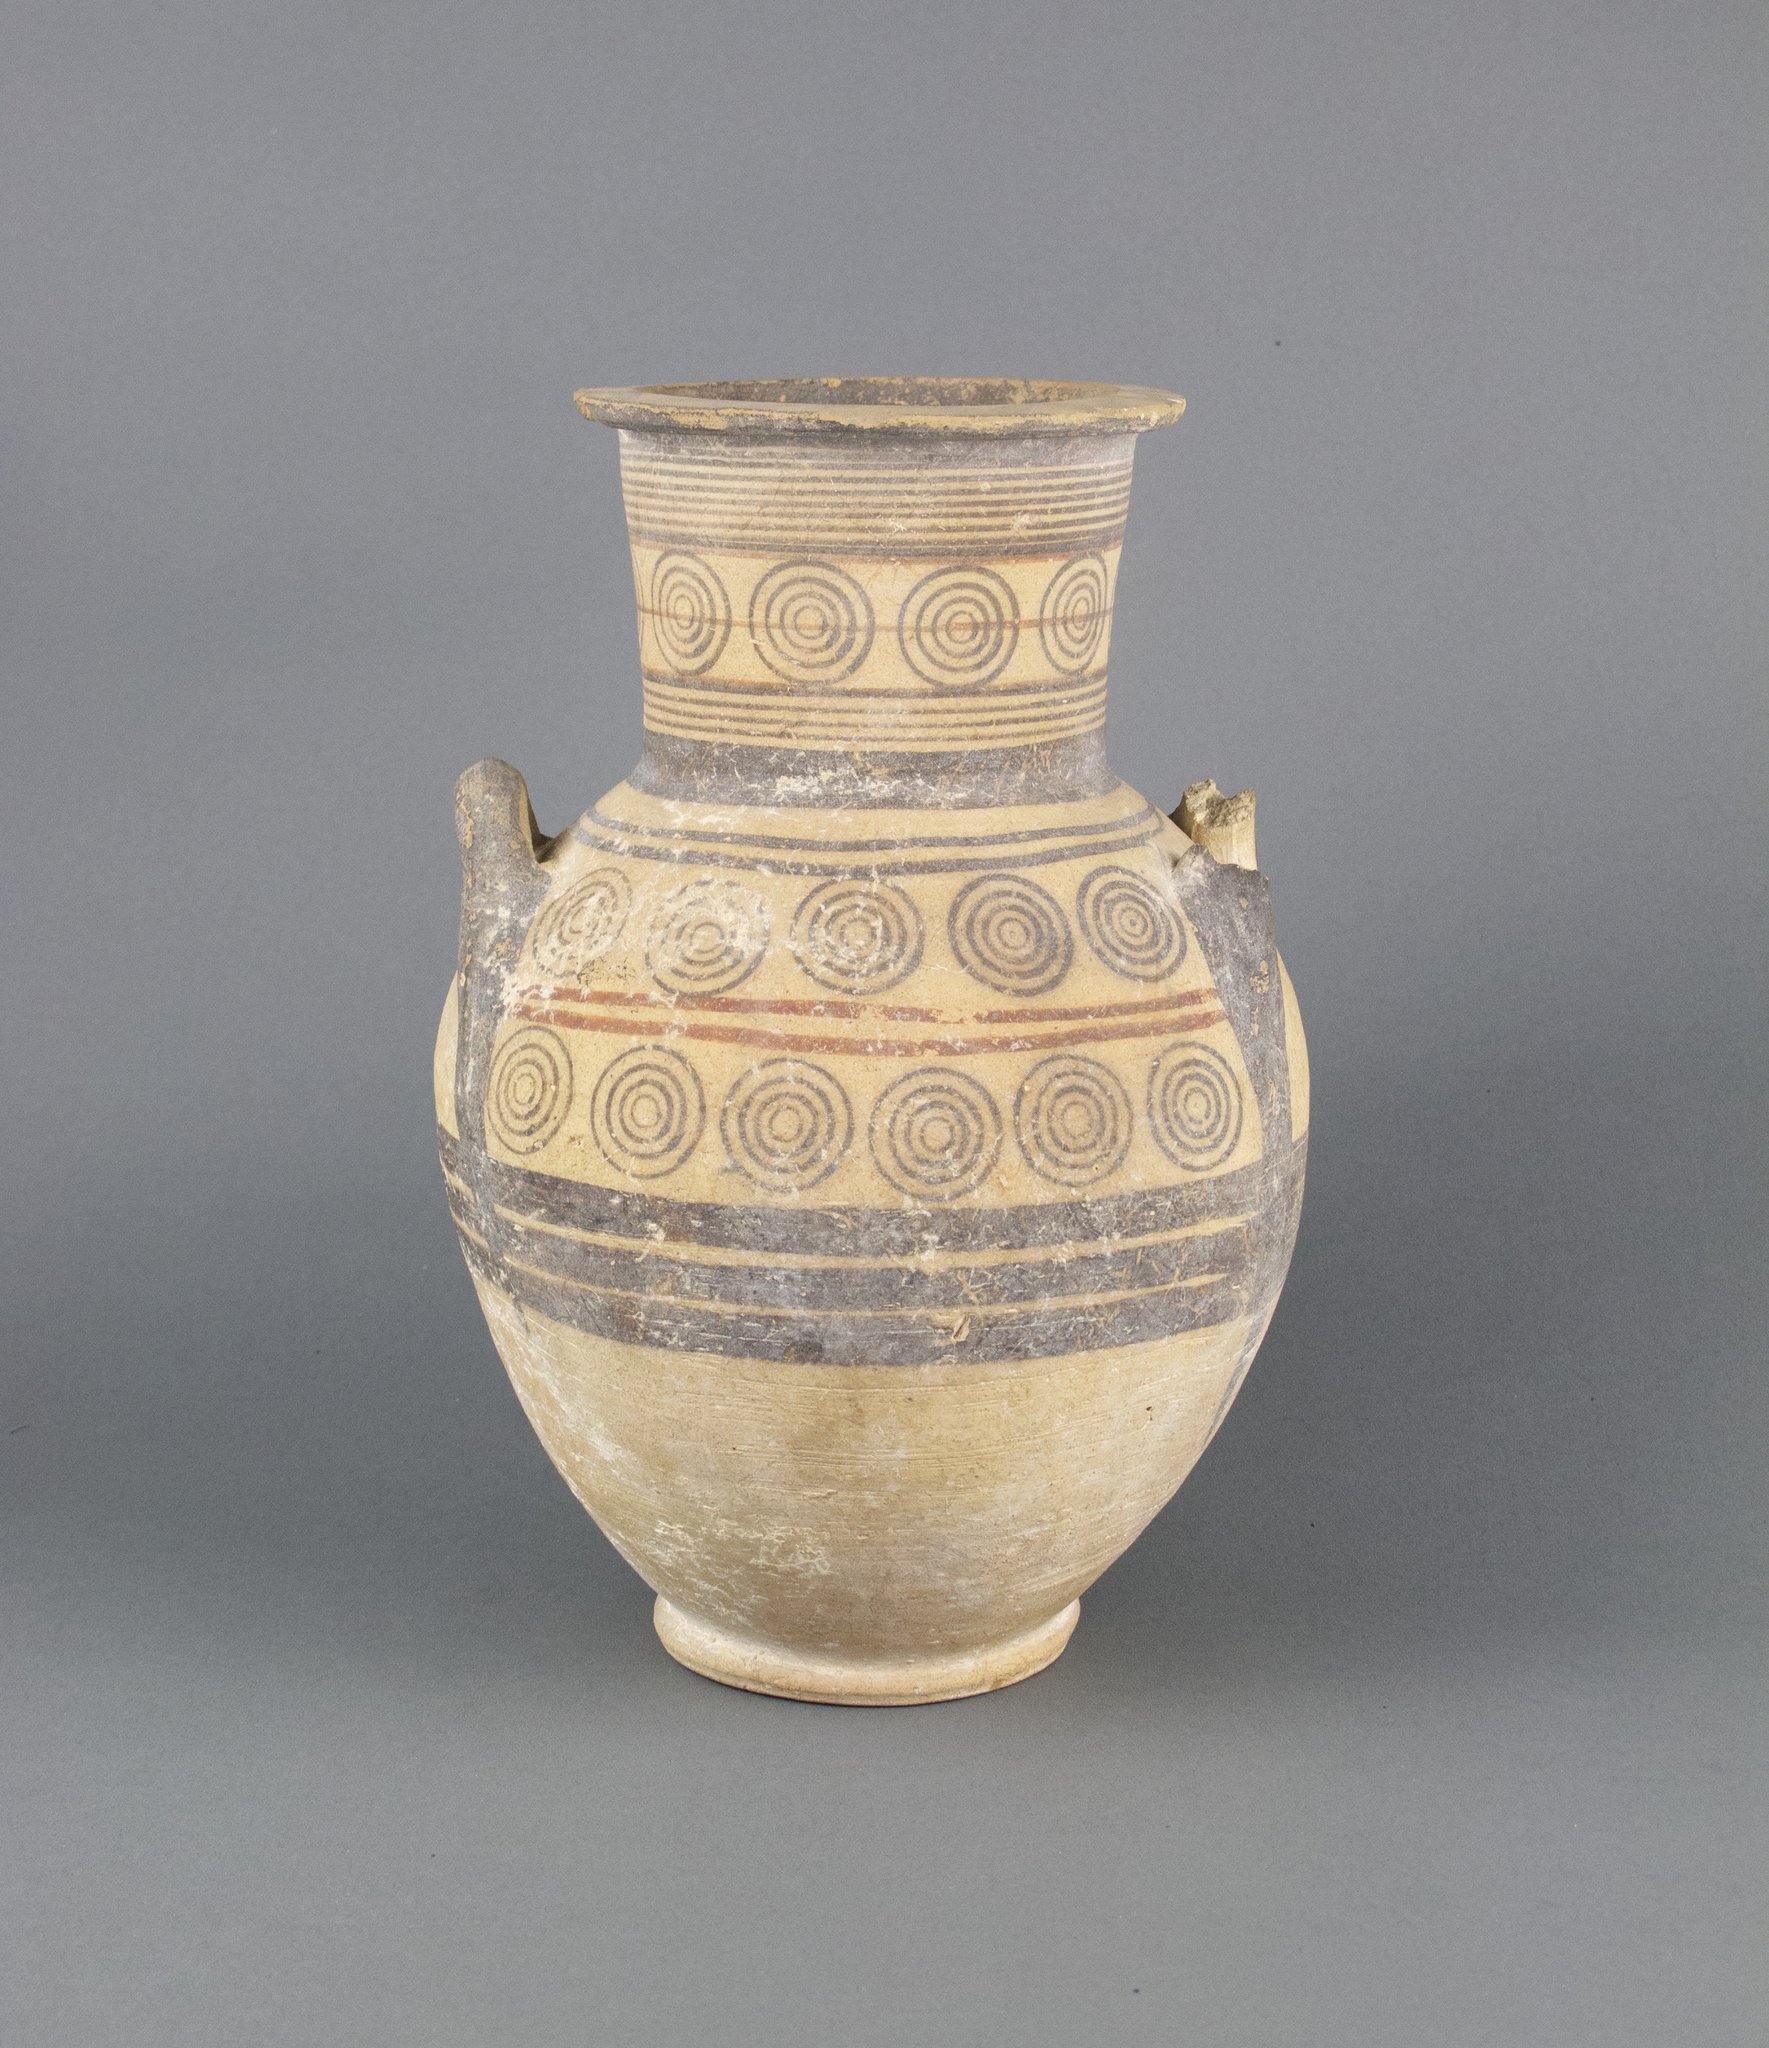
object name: amphora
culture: cypriot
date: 1125-1050 BCE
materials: terracotta